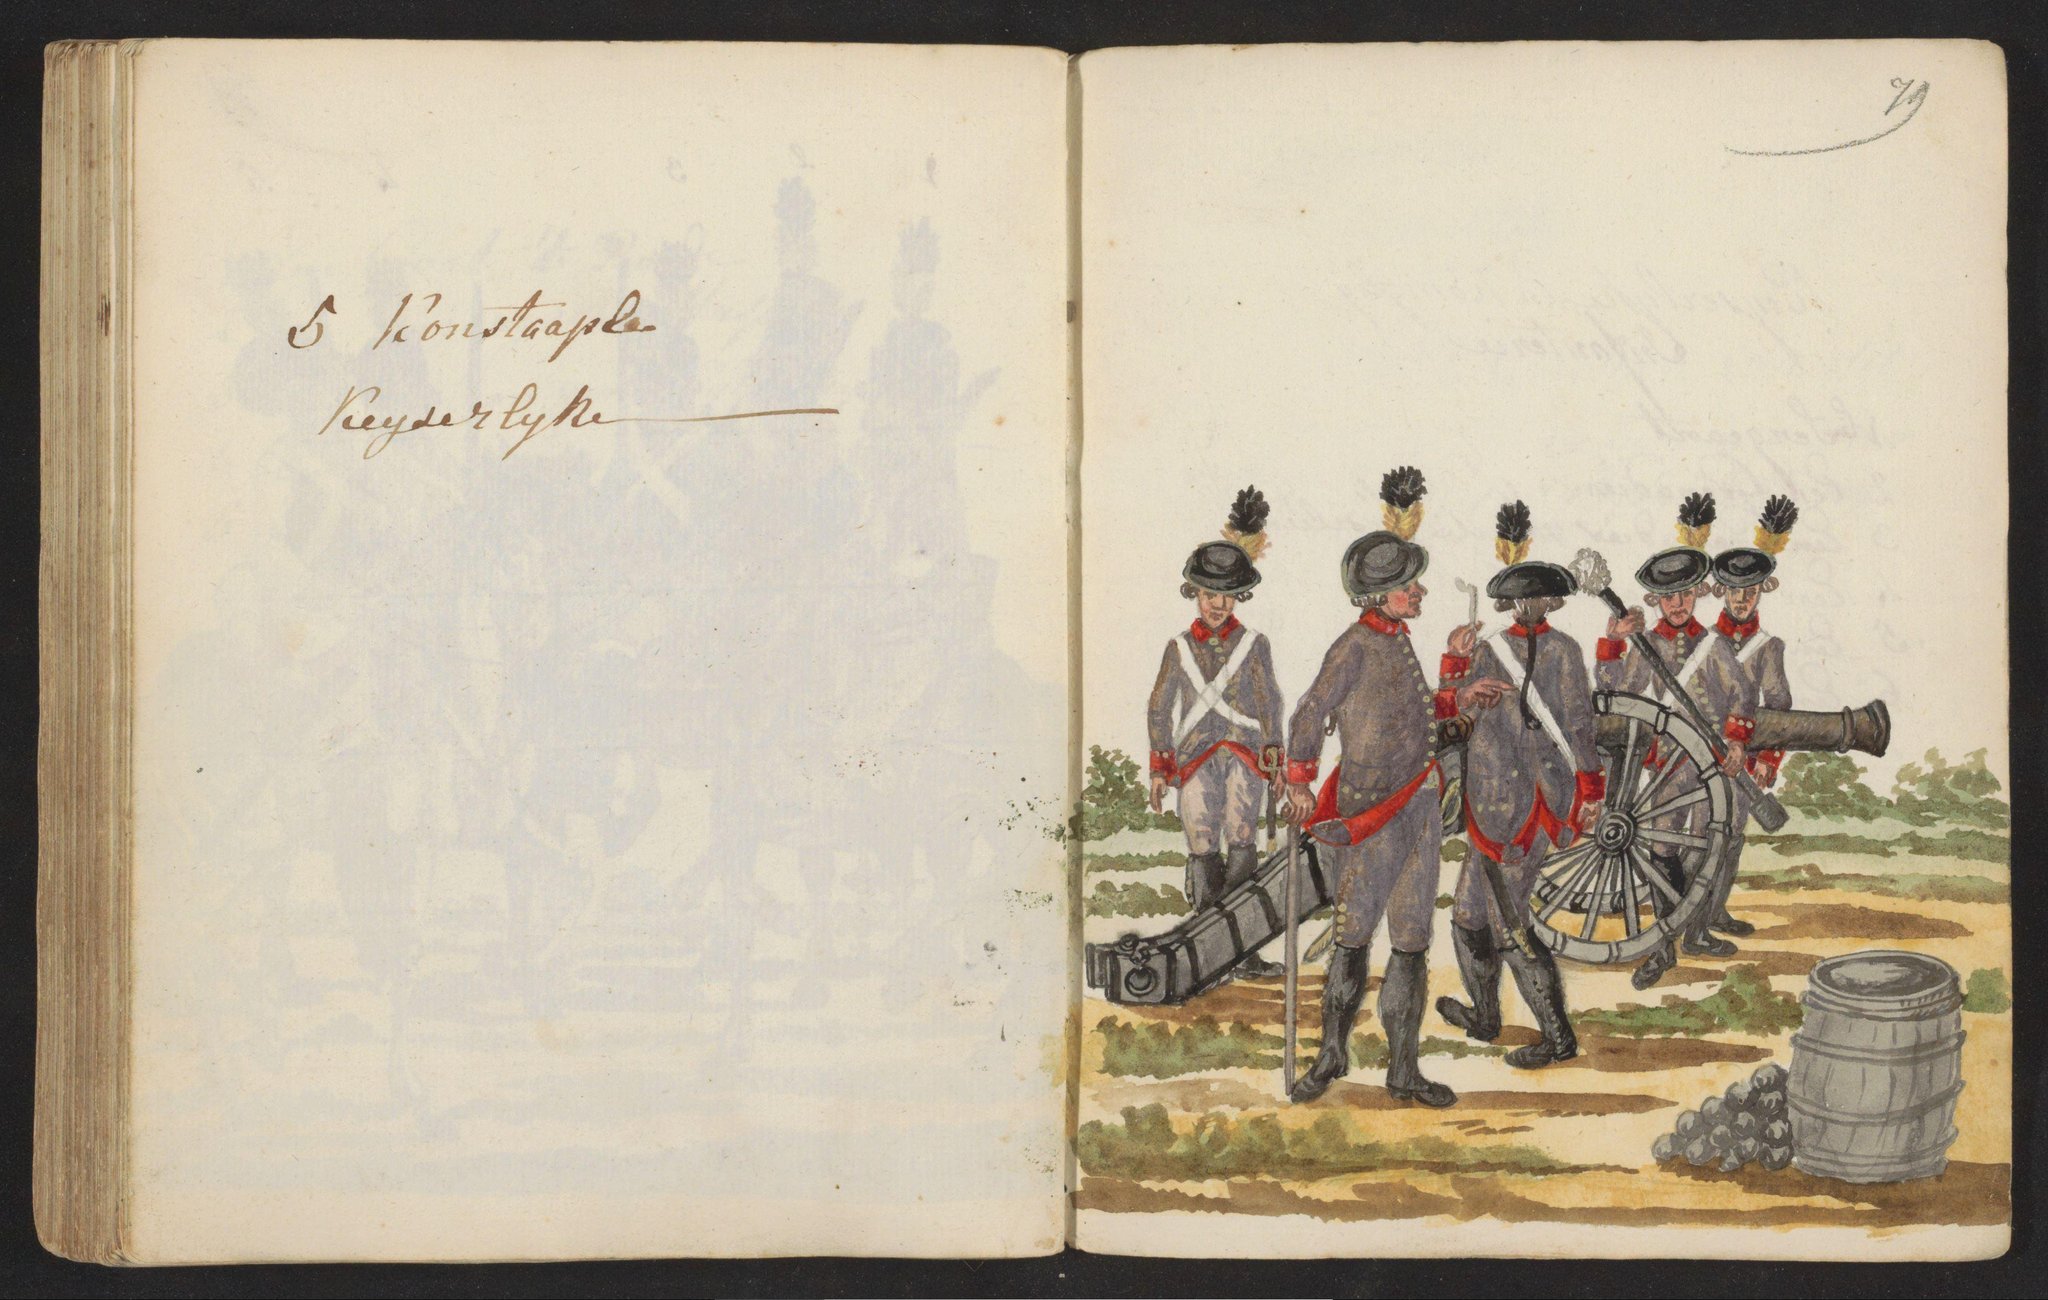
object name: drawing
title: Uniformen van keizerlijke konstabels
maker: s.g. casten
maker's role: draughtsman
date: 1795-1796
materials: paper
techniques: writing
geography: amsterdam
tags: (military) uniforms (+ artillery), patriots (1780-1795)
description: Vijf konstabels van de Oostenrijkse keizerlijke troepen, bij een kanon, ca. 1788-1795. Onderdeel van het derde hoofdstuk over de nieuwe uniformen in de periode na het herstel van de prins van Oranje en de komst van de Pruisische troepen in Holland in 1787. In het schetsboek met gekleurde tekeningen van de uniformen van militairen en leden van de schutterij uit de periode 1770 tot 1795-1796.